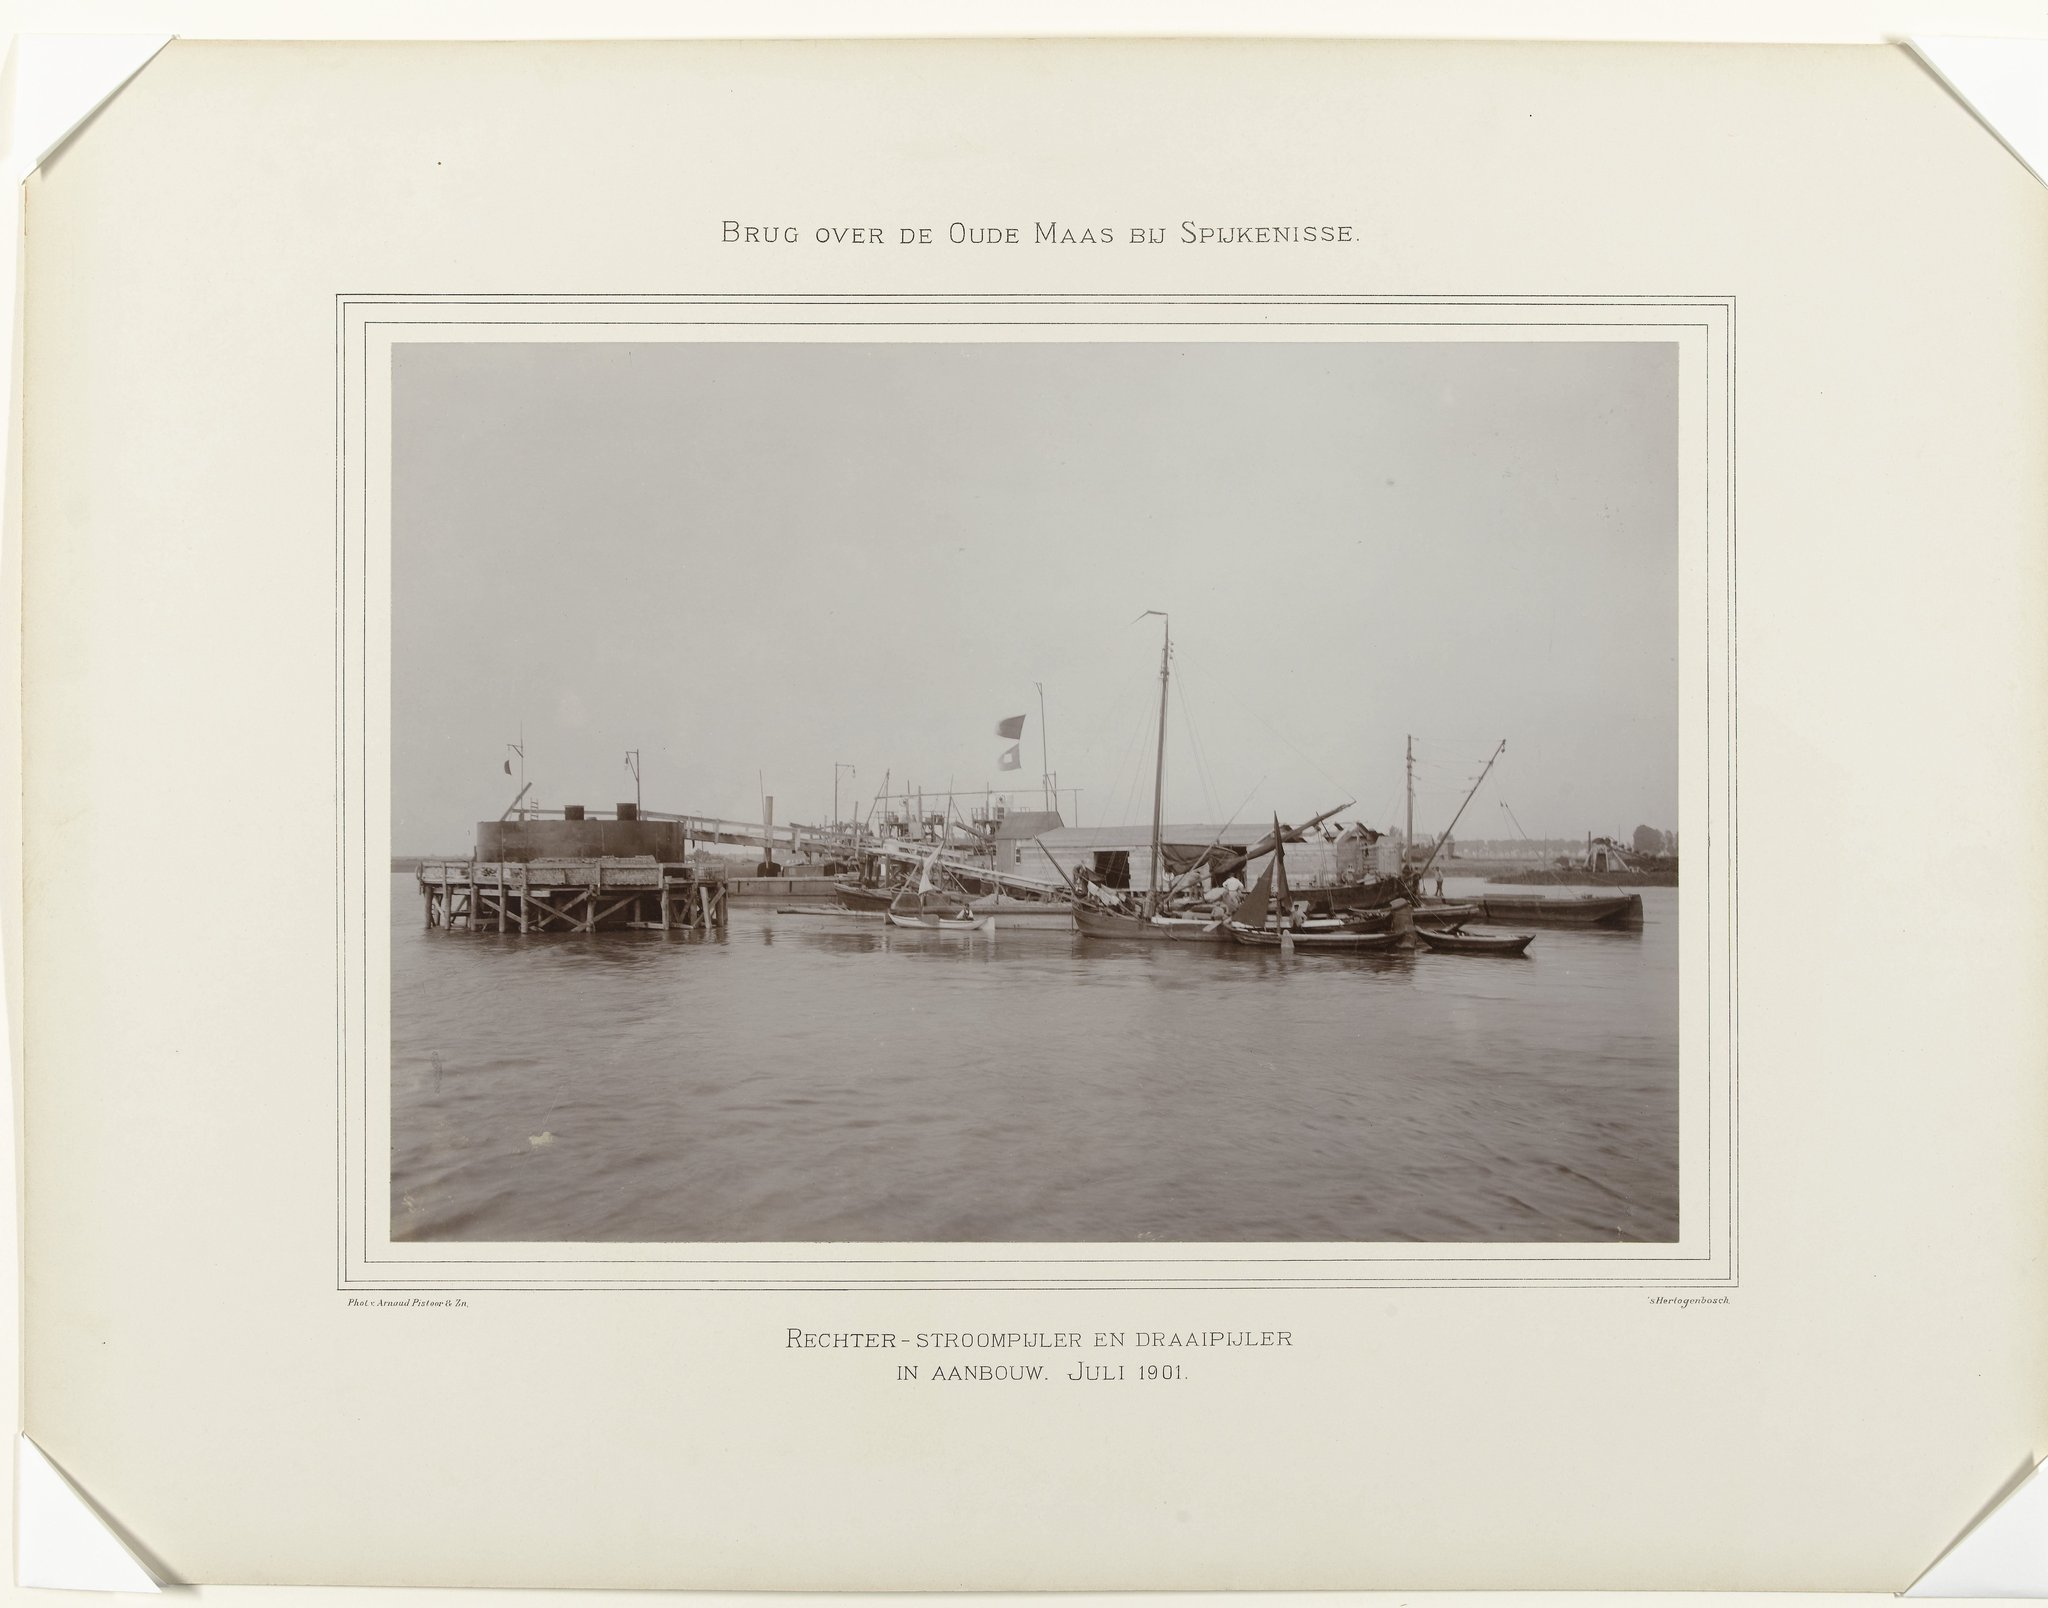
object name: photograph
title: Bouw van de rechter stroompijler en draaipijler voor de Brug over de Oude Maas bij Spijkenisse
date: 1901-1907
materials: cardboard, photographic support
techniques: collodion silver print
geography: den bosch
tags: bridge, building-site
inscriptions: date